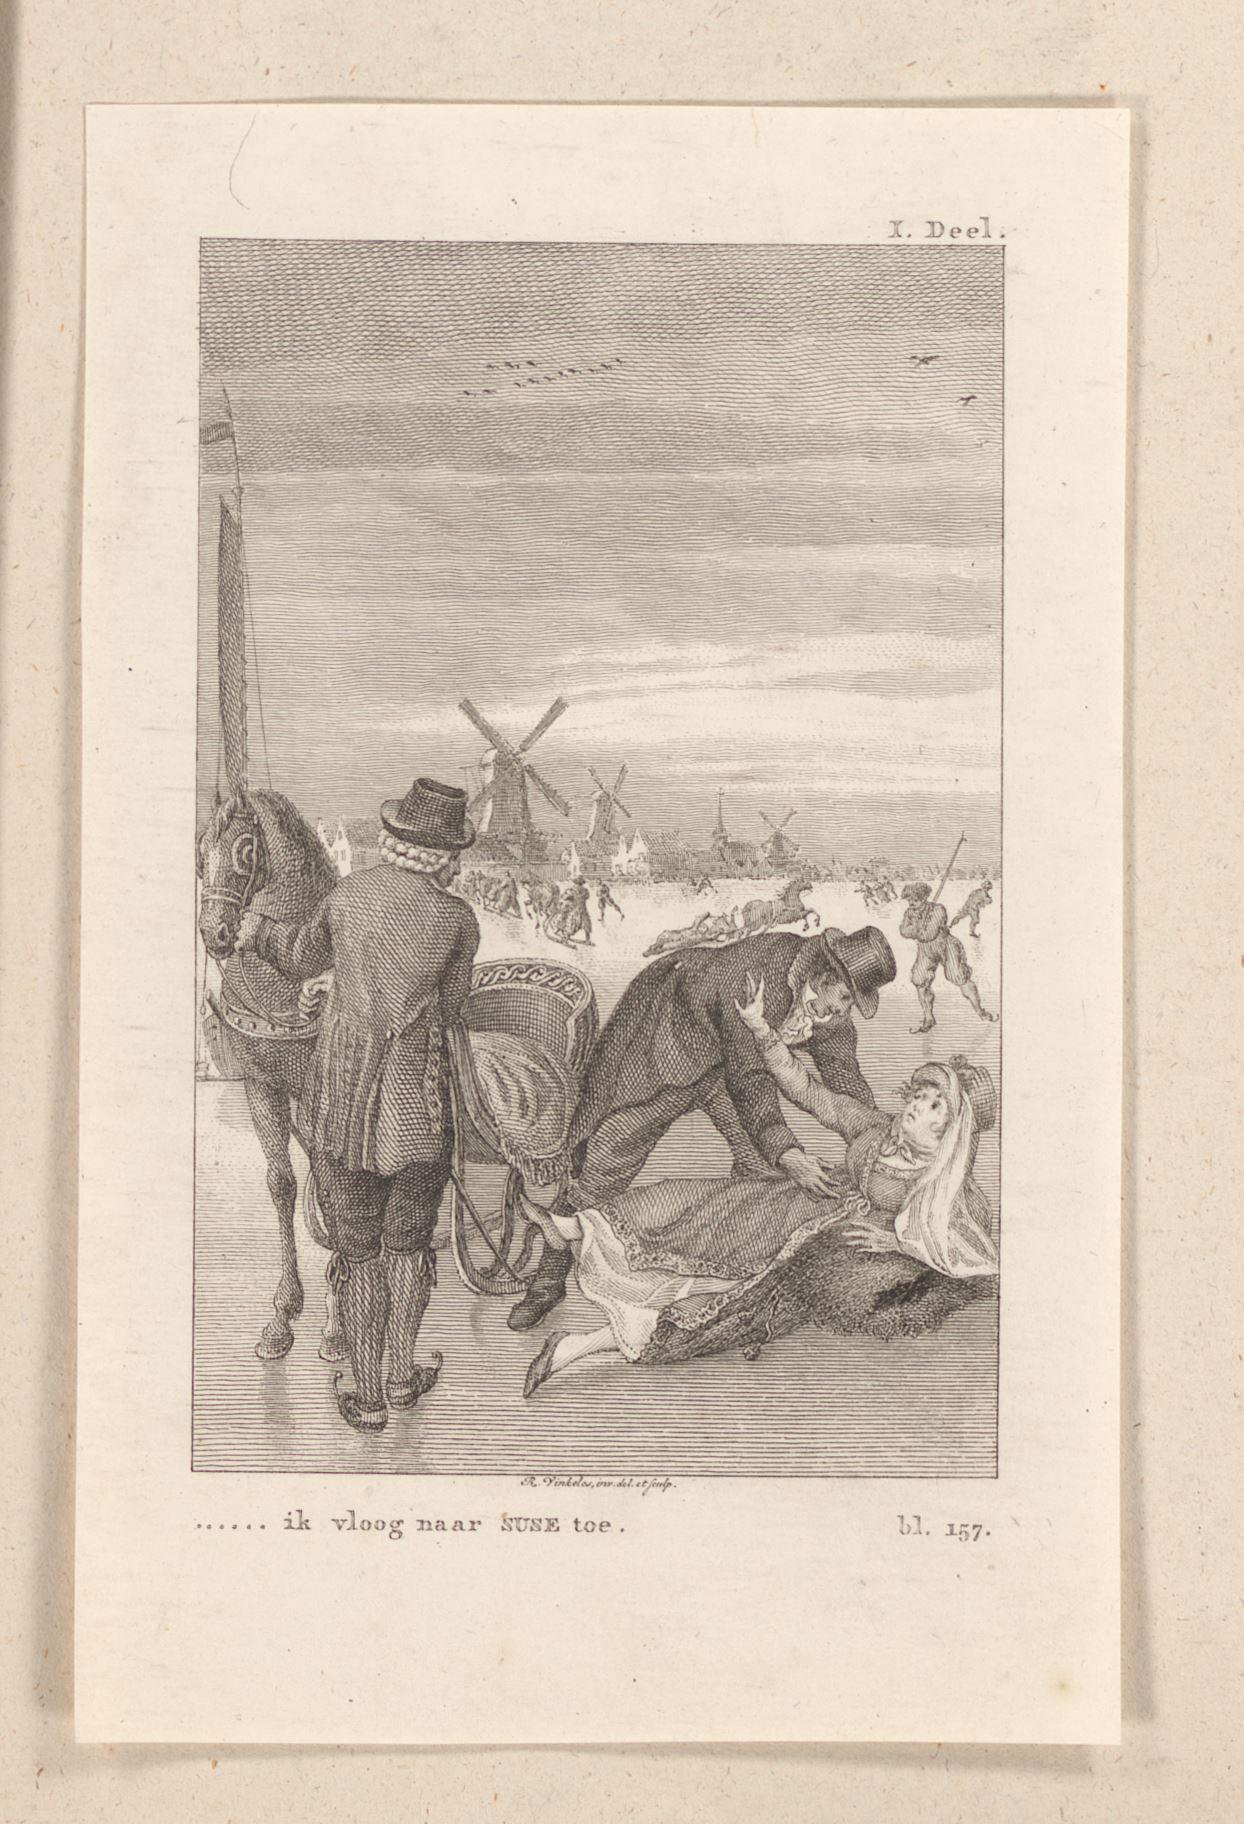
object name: book illustration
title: Susanna Bronkhorst glijdt uit op het ijs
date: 1806-1807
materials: paper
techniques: engraving, etching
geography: amsterdam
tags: slipping, skates (winter sports), ice ~ state of water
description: IJslandschap met molens. Een vrouw naast een slede is uitgegleden en wordt geholpen door een man. Daaronder de tekst: ... ik vloog naar Suse toe. De prent maakt deel uit van een album.